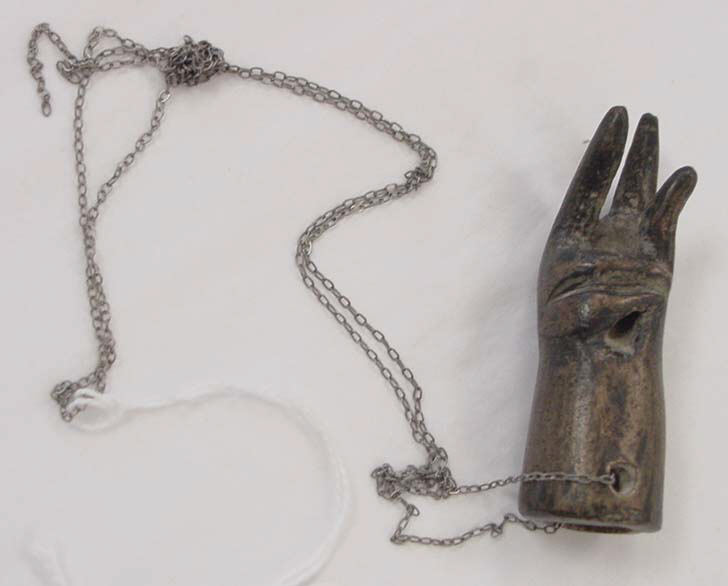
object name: necklace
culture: greek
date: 1200-700 BCE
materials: metal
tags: hands